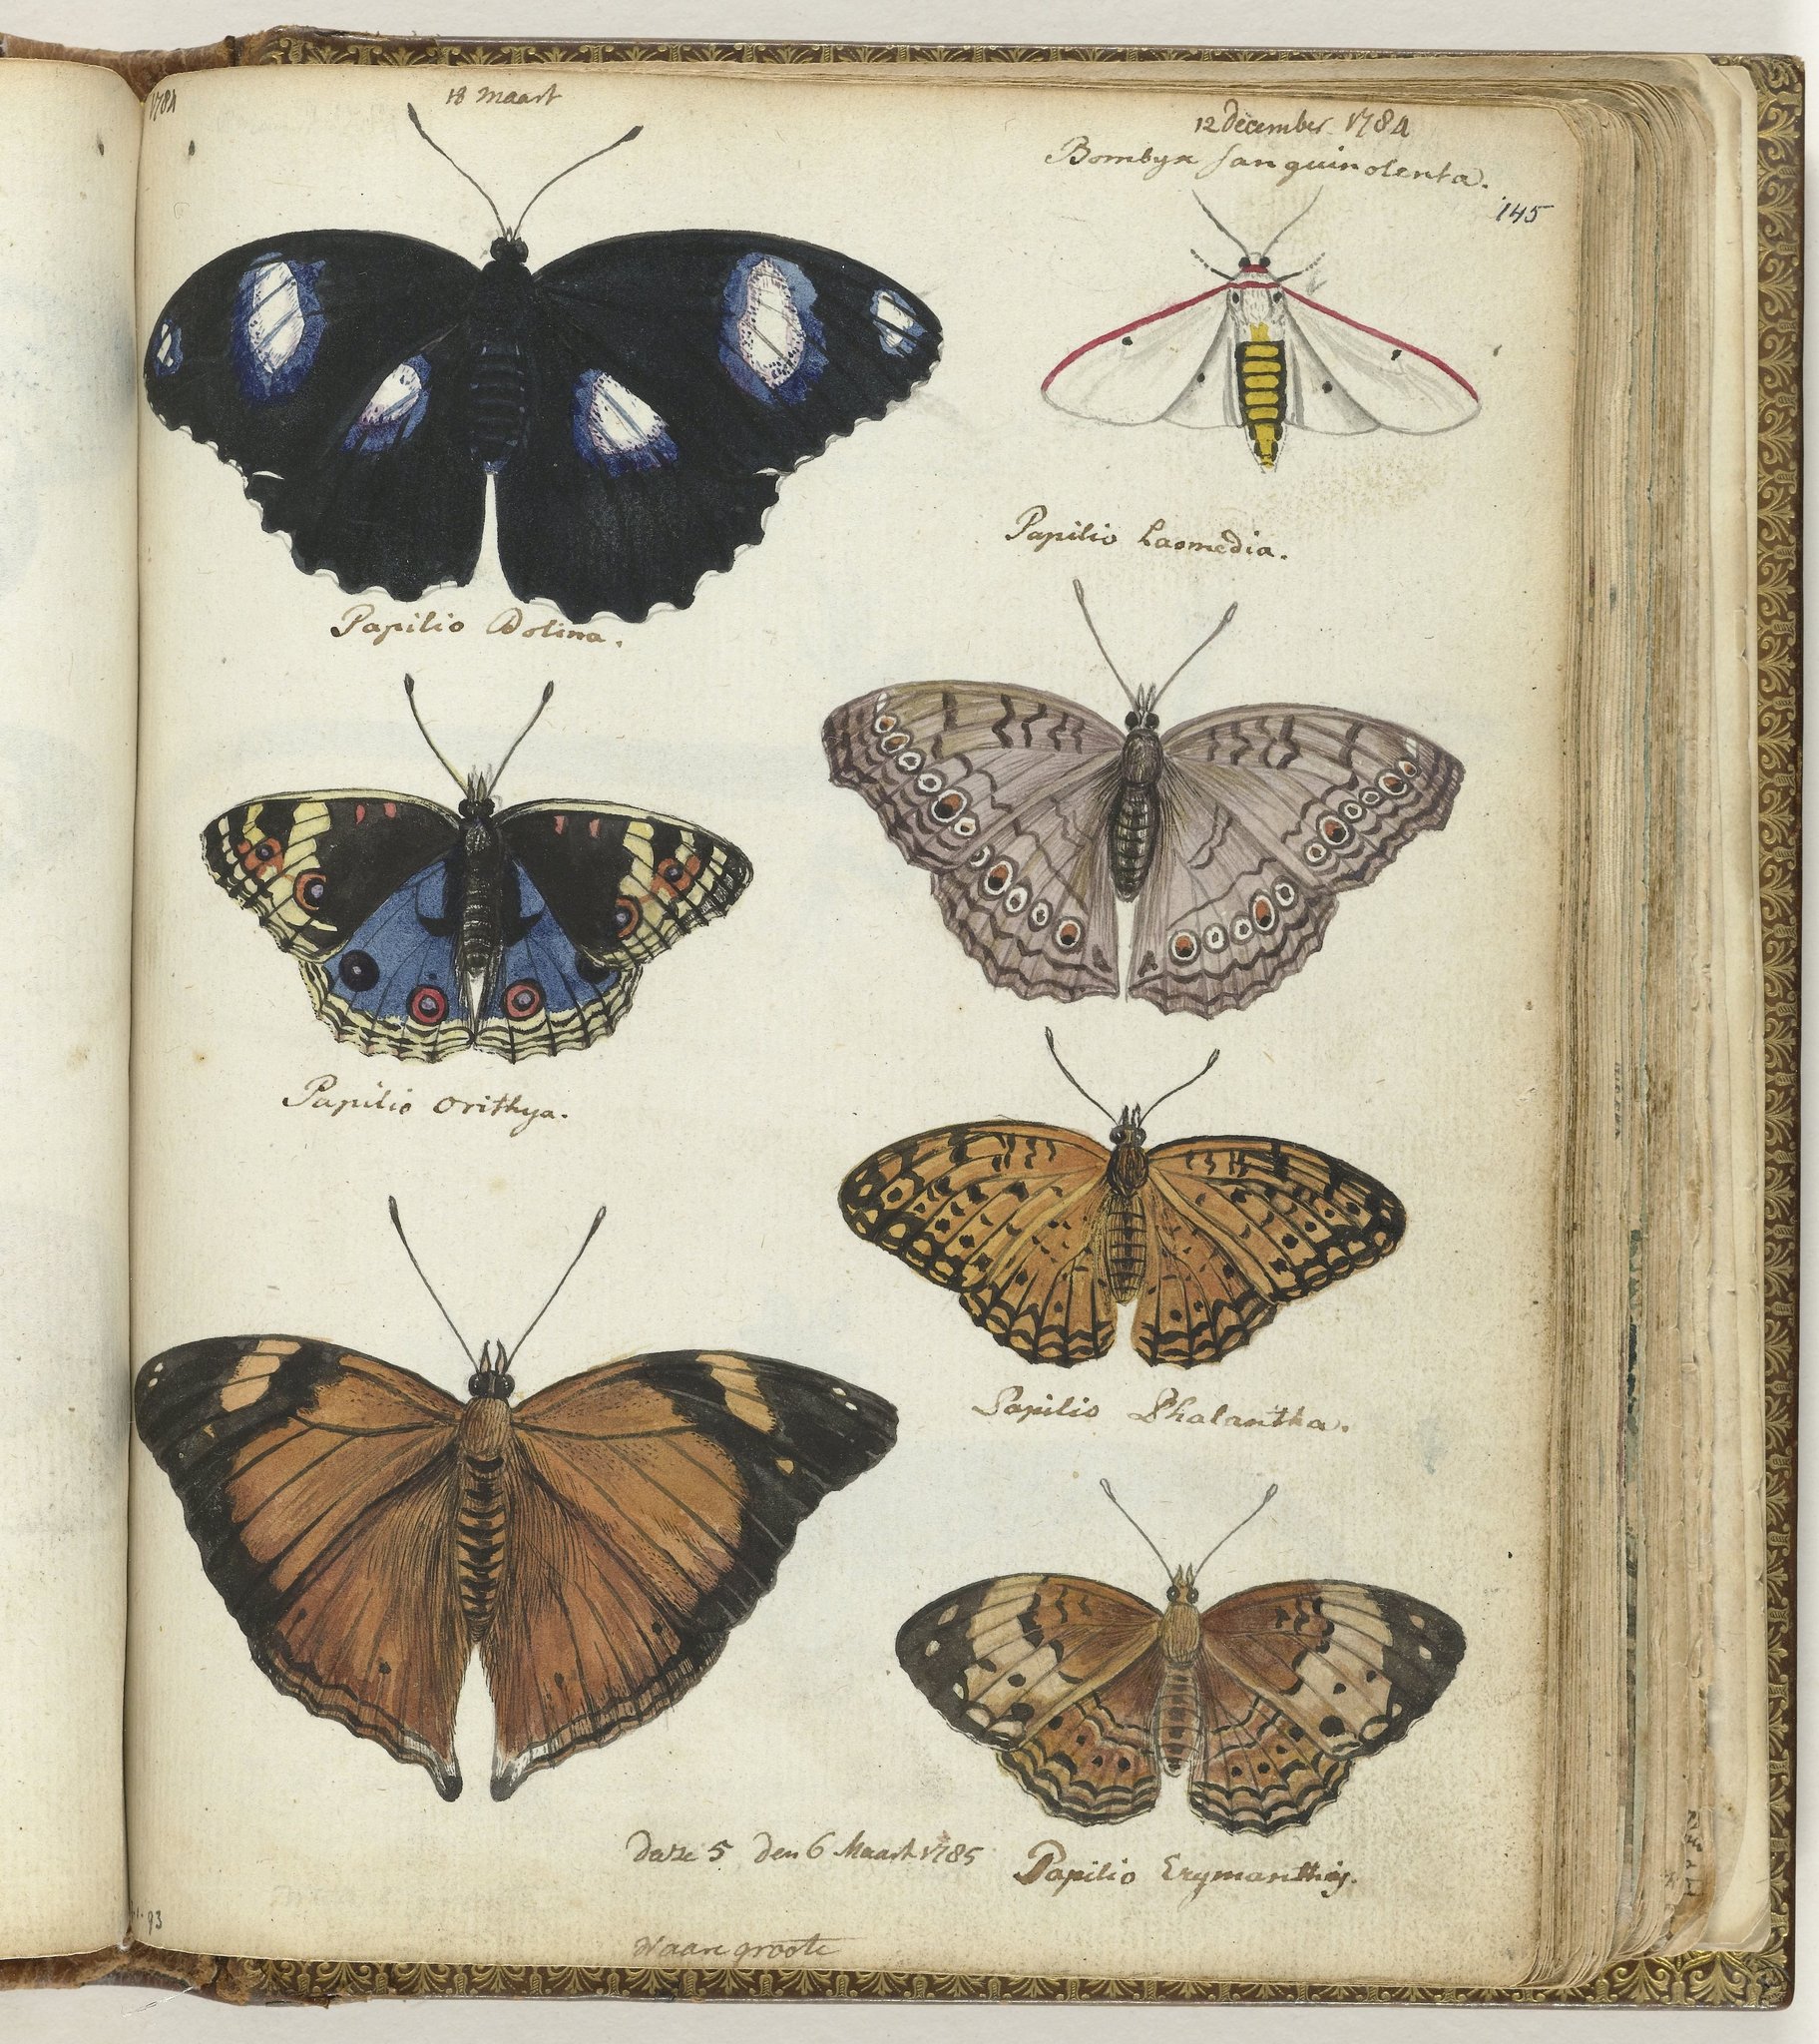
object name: drawing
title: Javaanse vlinders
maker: jan brandes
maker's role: draughtsman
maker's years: 1743-1808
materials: paper, pencil, watercolor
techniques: brush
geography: jakarta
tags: insects: butterfly, indonesia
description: Kleurtekening van zeven Javaanse vlinders en motachtigen. Op ware grootte. Met opschrift. Onderdeel uit het schetsboek van Jan Brandes, dl. 1 (1808), p. 145.